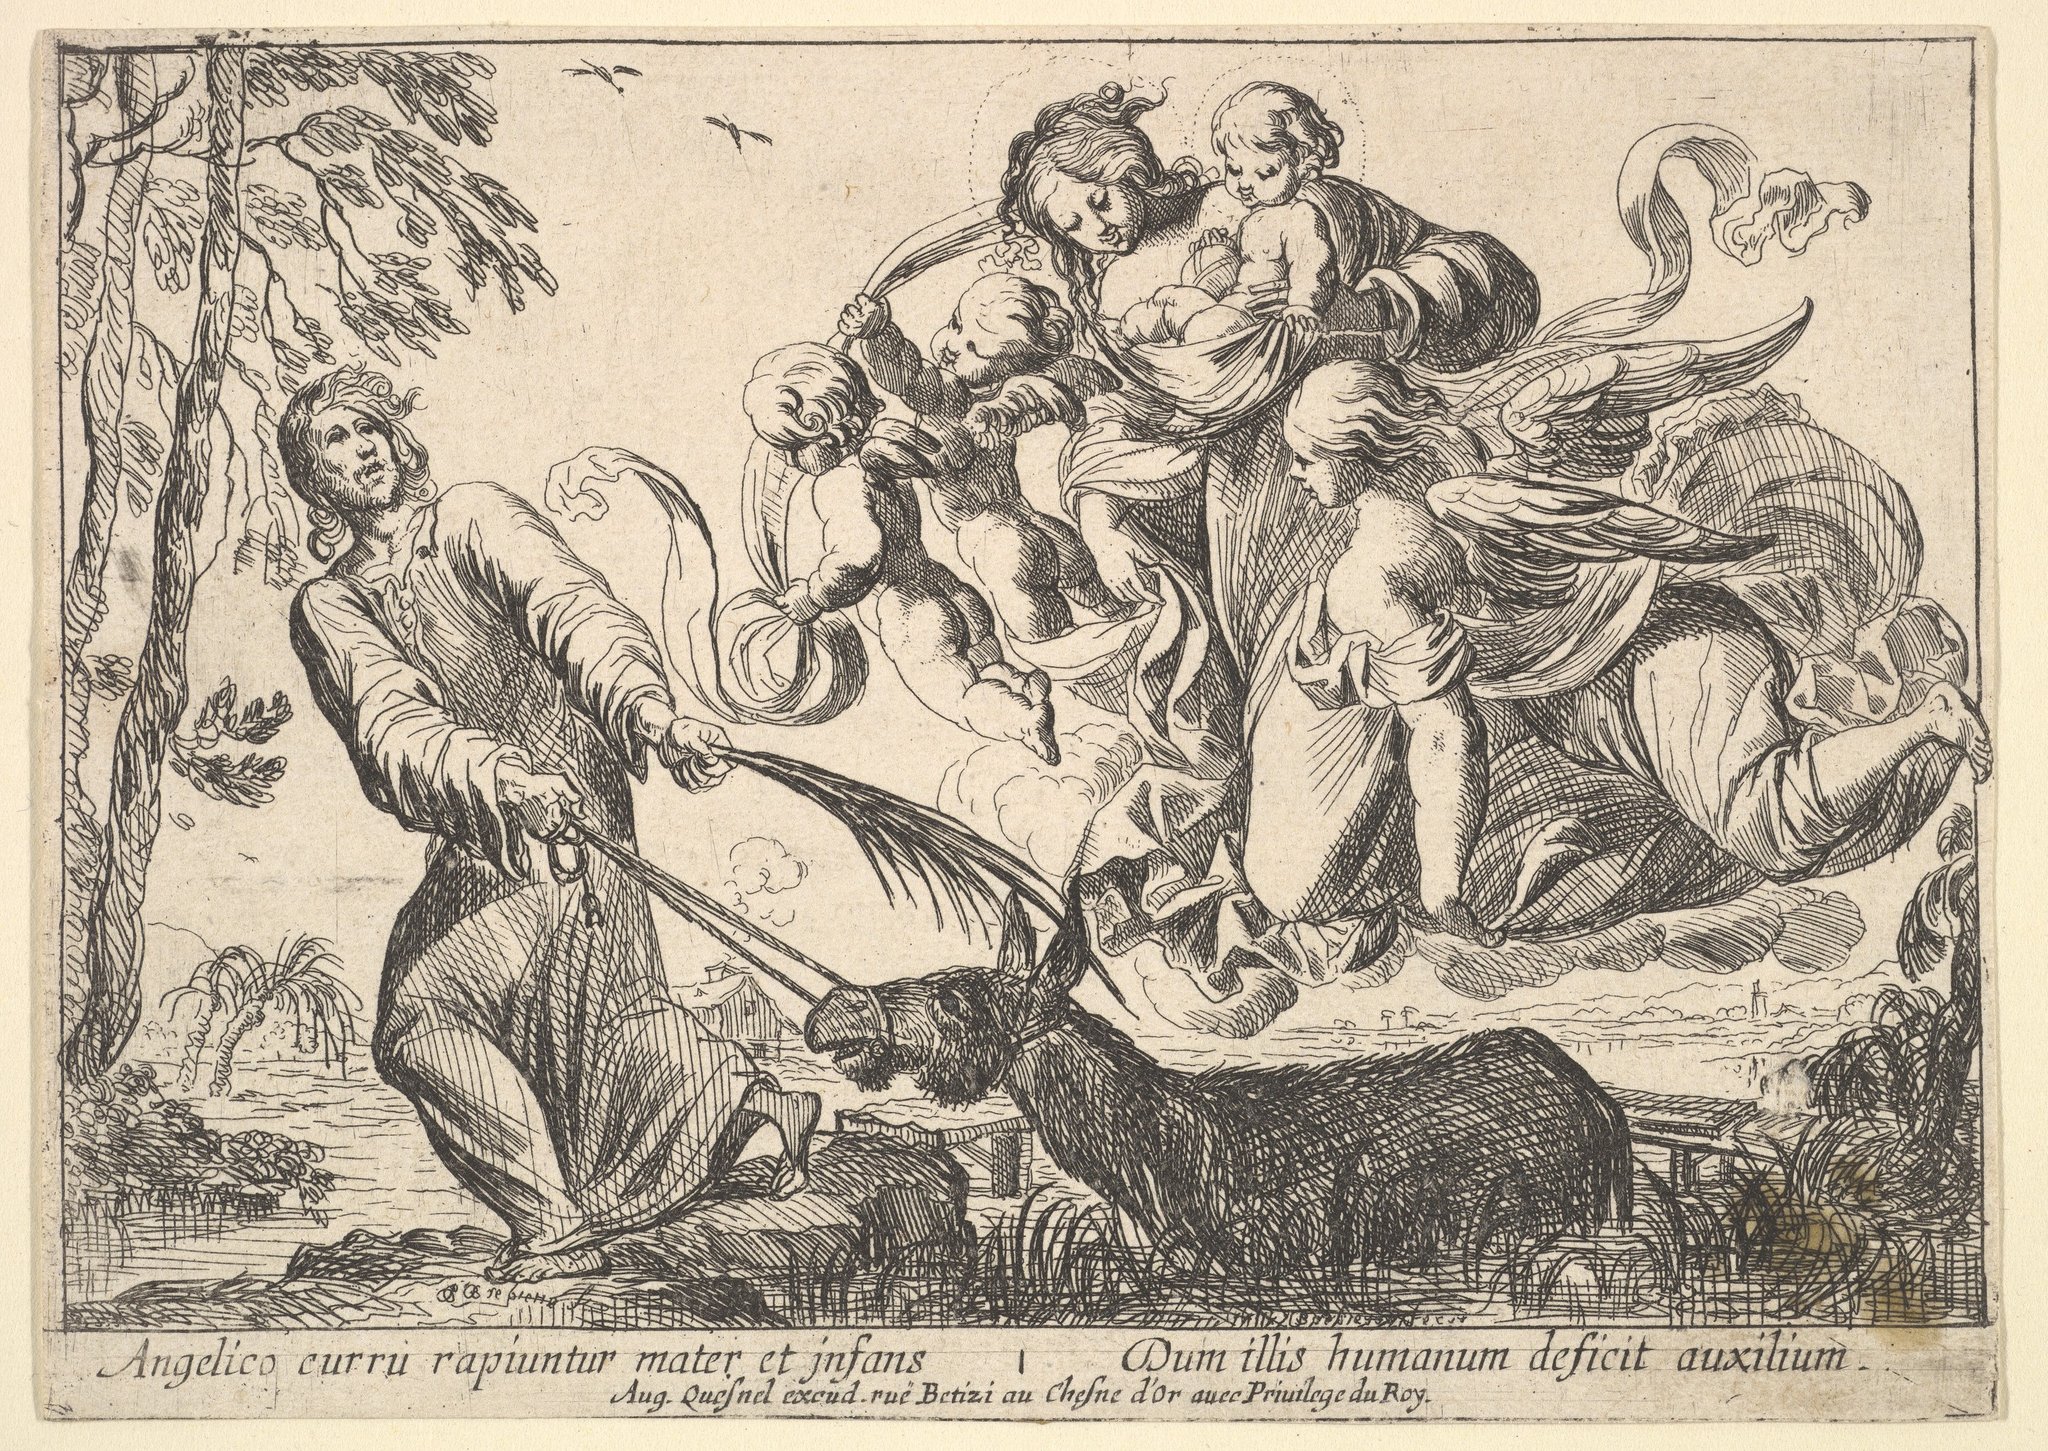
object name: print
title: Angels Lifting Virgin and Child, from "Episodes from the New Testament"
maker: pierre brebiette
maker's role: artist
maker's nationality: french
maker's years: 1598-1642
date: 1610-1642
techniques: etching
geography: france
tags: animals,men,trees,angels,madonna and child